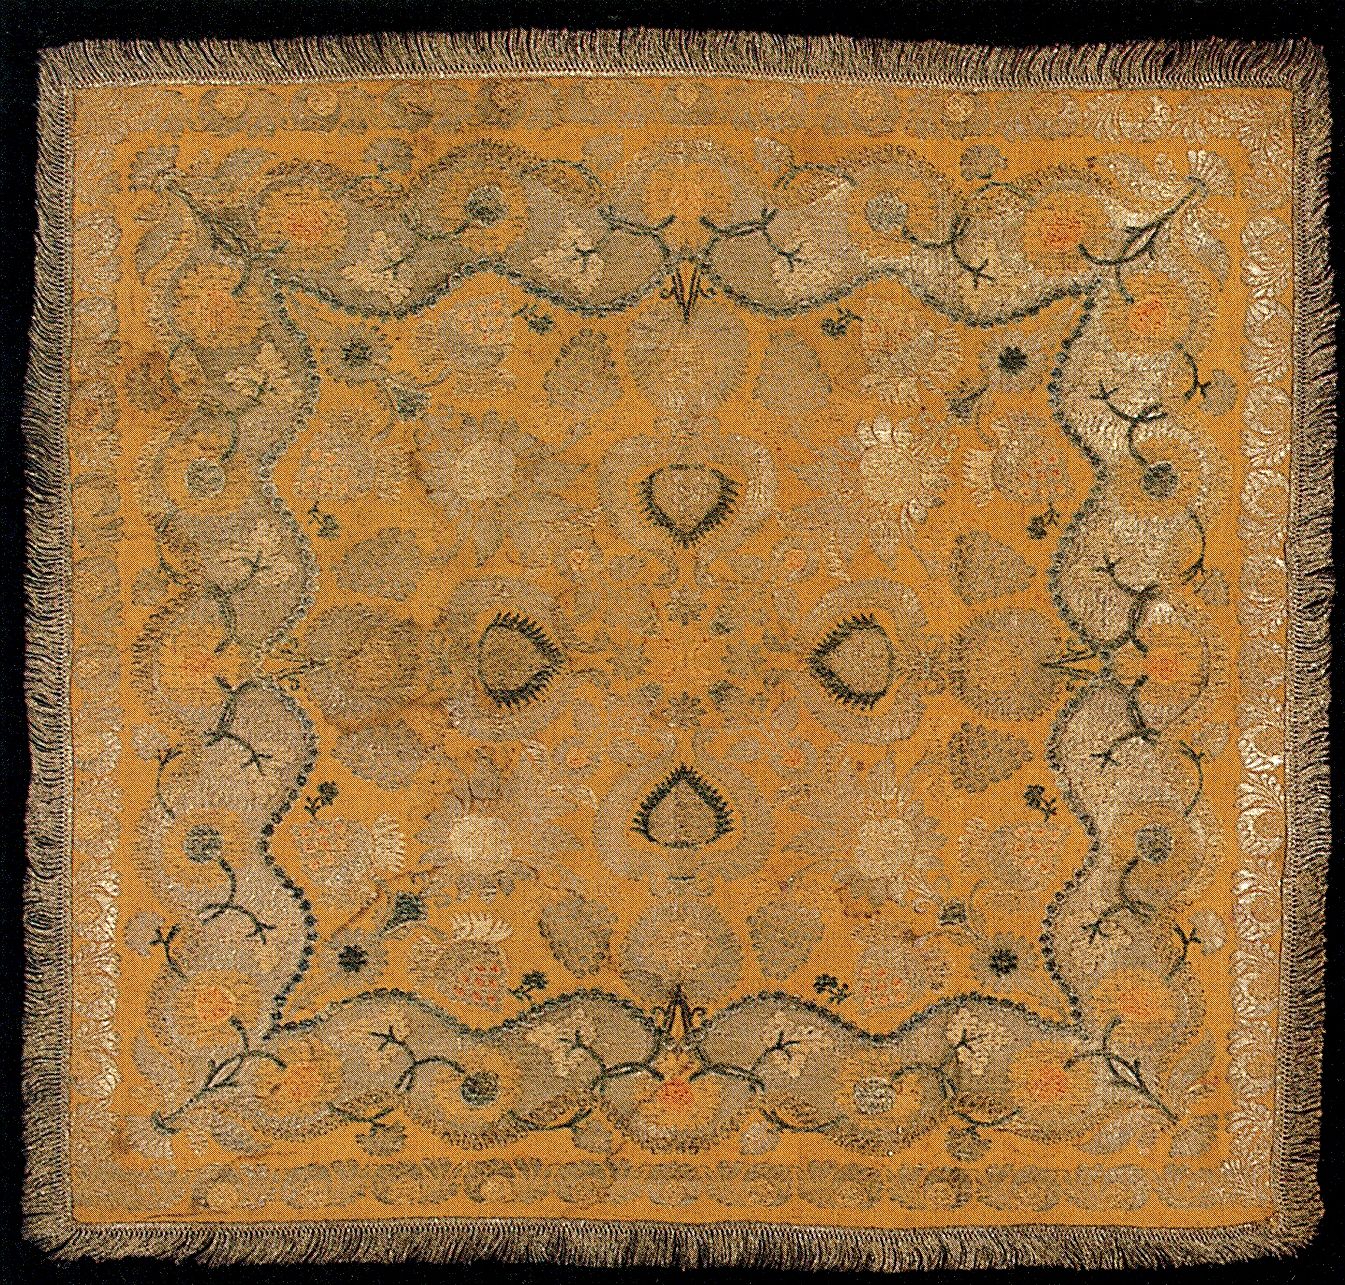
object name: textile cover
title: Cover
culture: russian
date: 1801-1900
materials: cotton, metal, silk